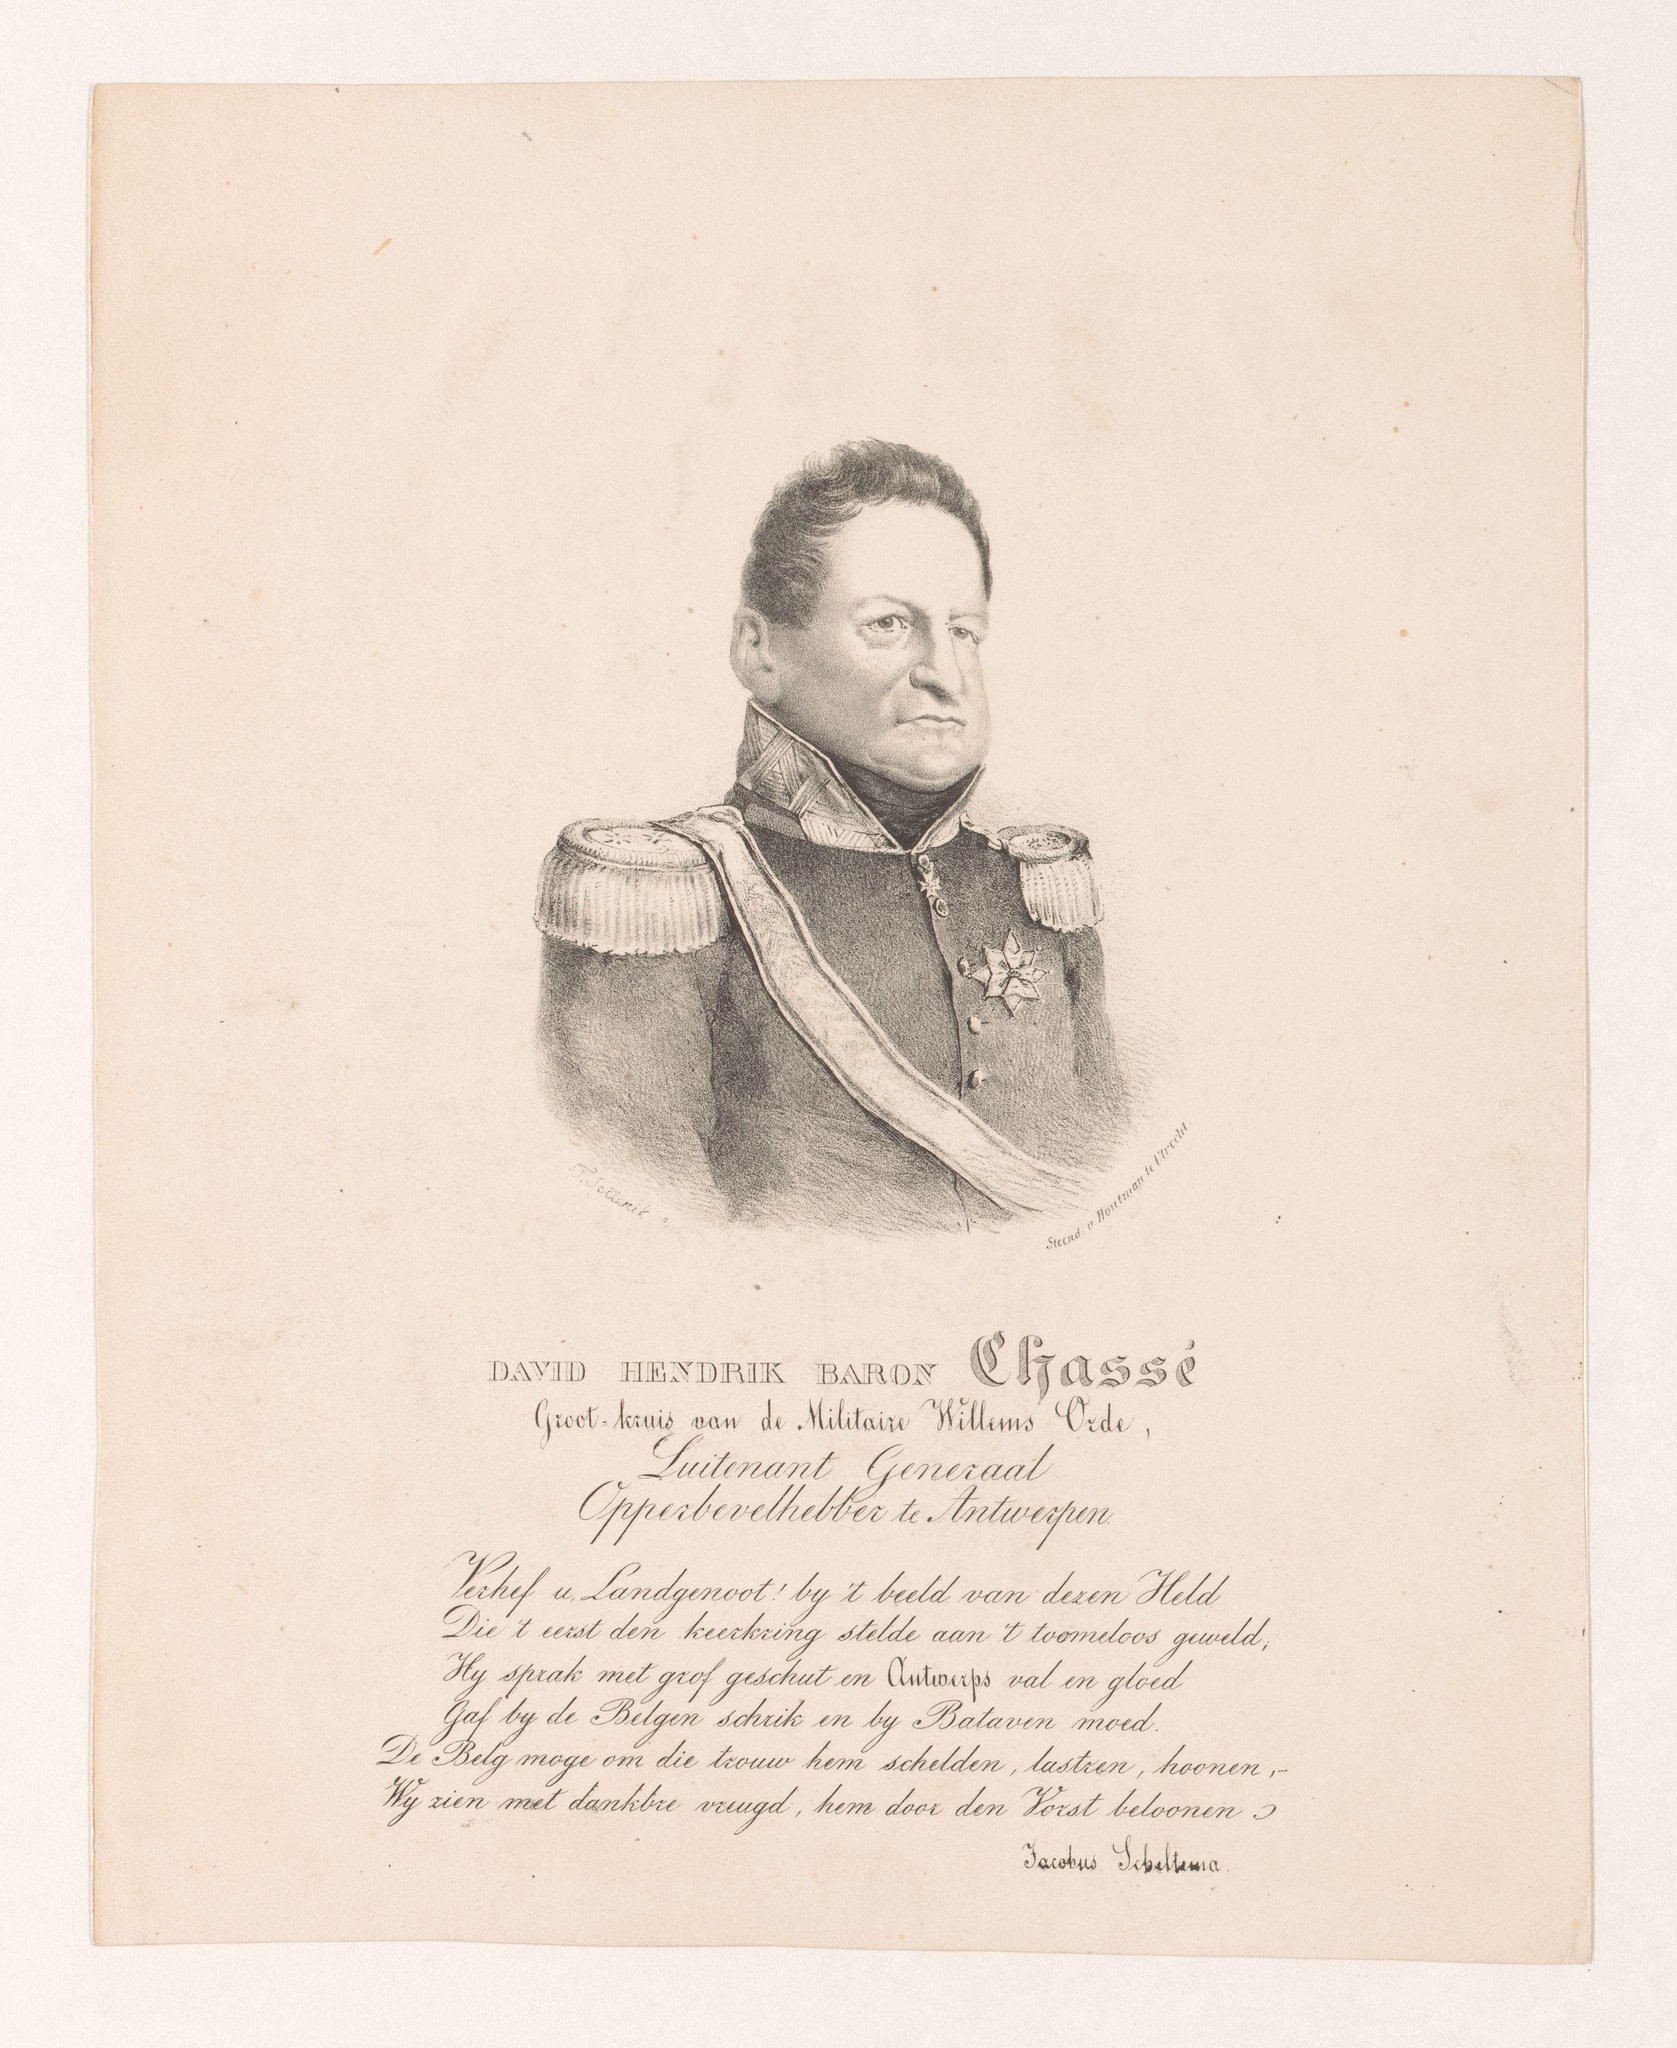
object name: print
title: David Hendrik Baron Chassé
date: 1828-1843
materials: paper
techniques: lithograph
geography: utrecht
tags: david hendrik baron chassé, historical persons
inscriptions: collector's mark: Lugt 2228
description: Onder het portret zijn titel en een zesregelig vers van Jacobus Scheltema.